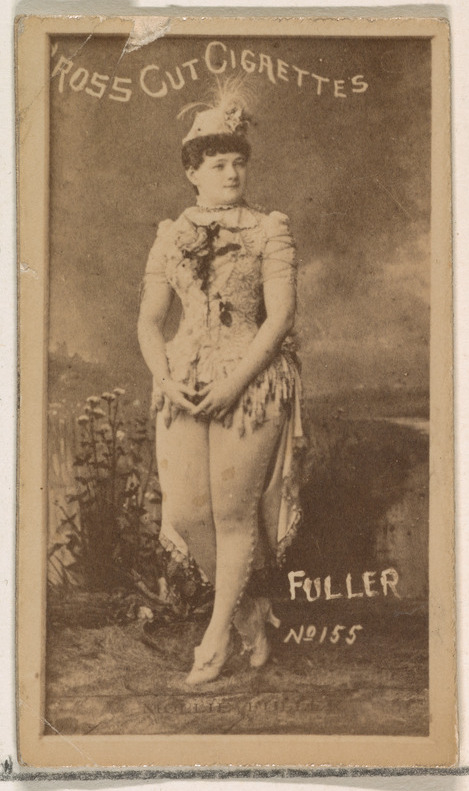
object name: print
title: Card Number 155, Fuller, from the Actors and Actresses series (N145-1) issued by Duke Sons & Co. to promote Cross Cut Cigarettes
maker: w. duke, sons & co.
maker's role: publisher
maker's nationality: american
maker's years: 1870-1920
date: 1880-1889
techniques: albumen silver print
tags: portraits,women,actresses